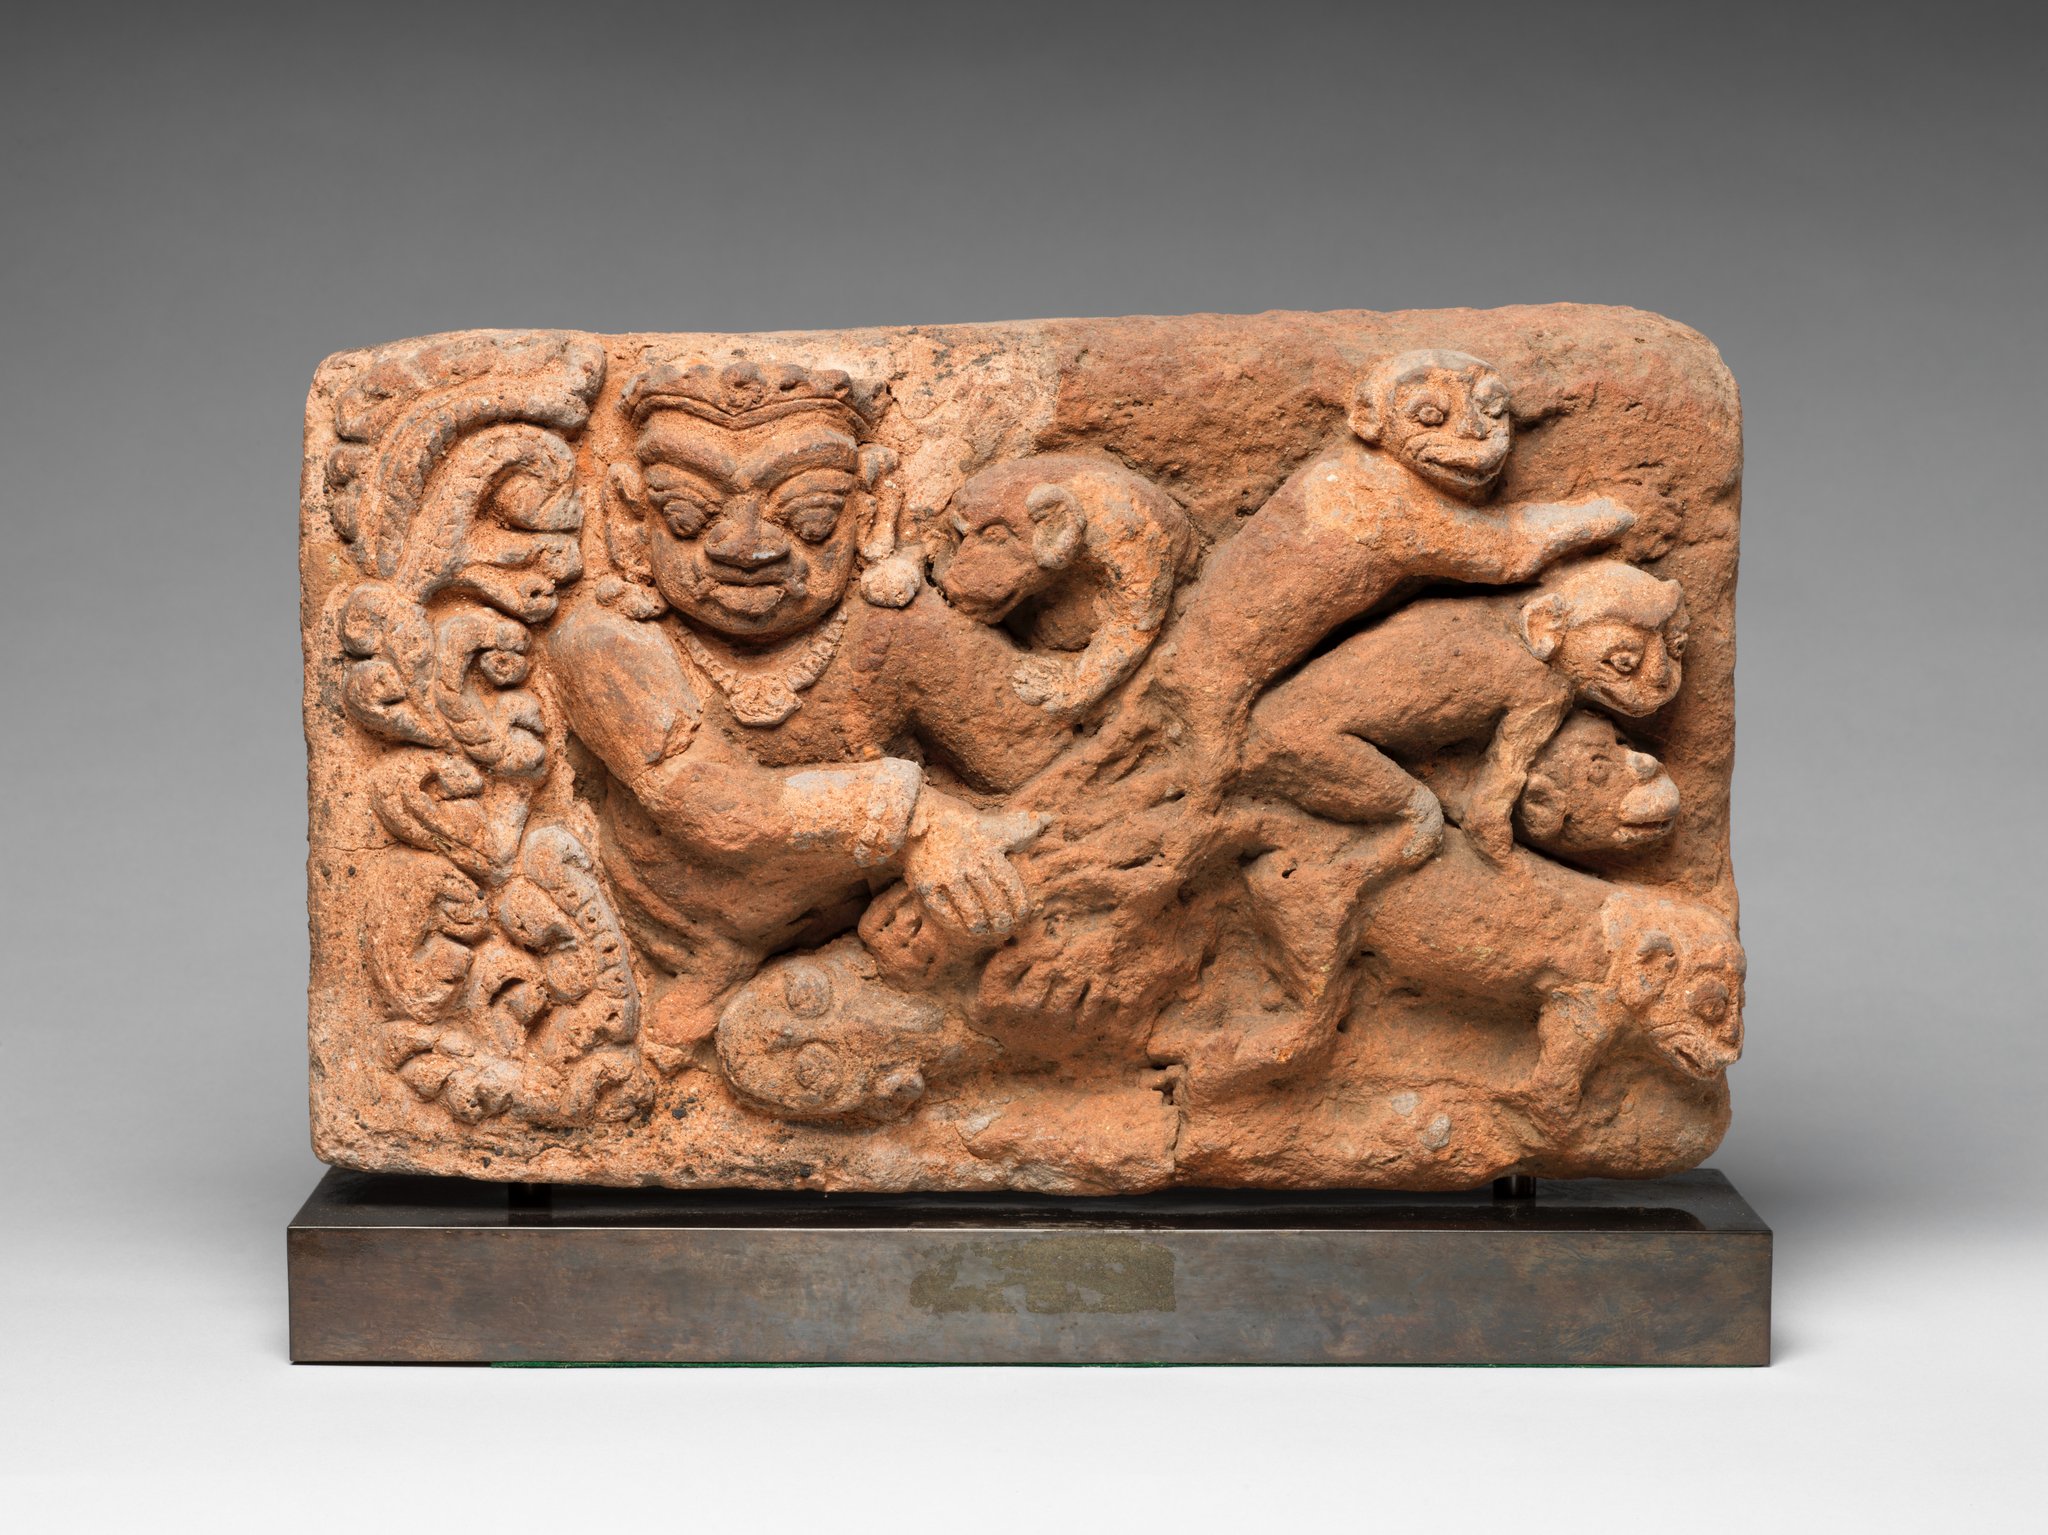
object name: relief plaque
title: Plaque with Ramayana Scene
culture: indonesian, javanese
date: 1201-1400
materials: terracotta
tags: animals